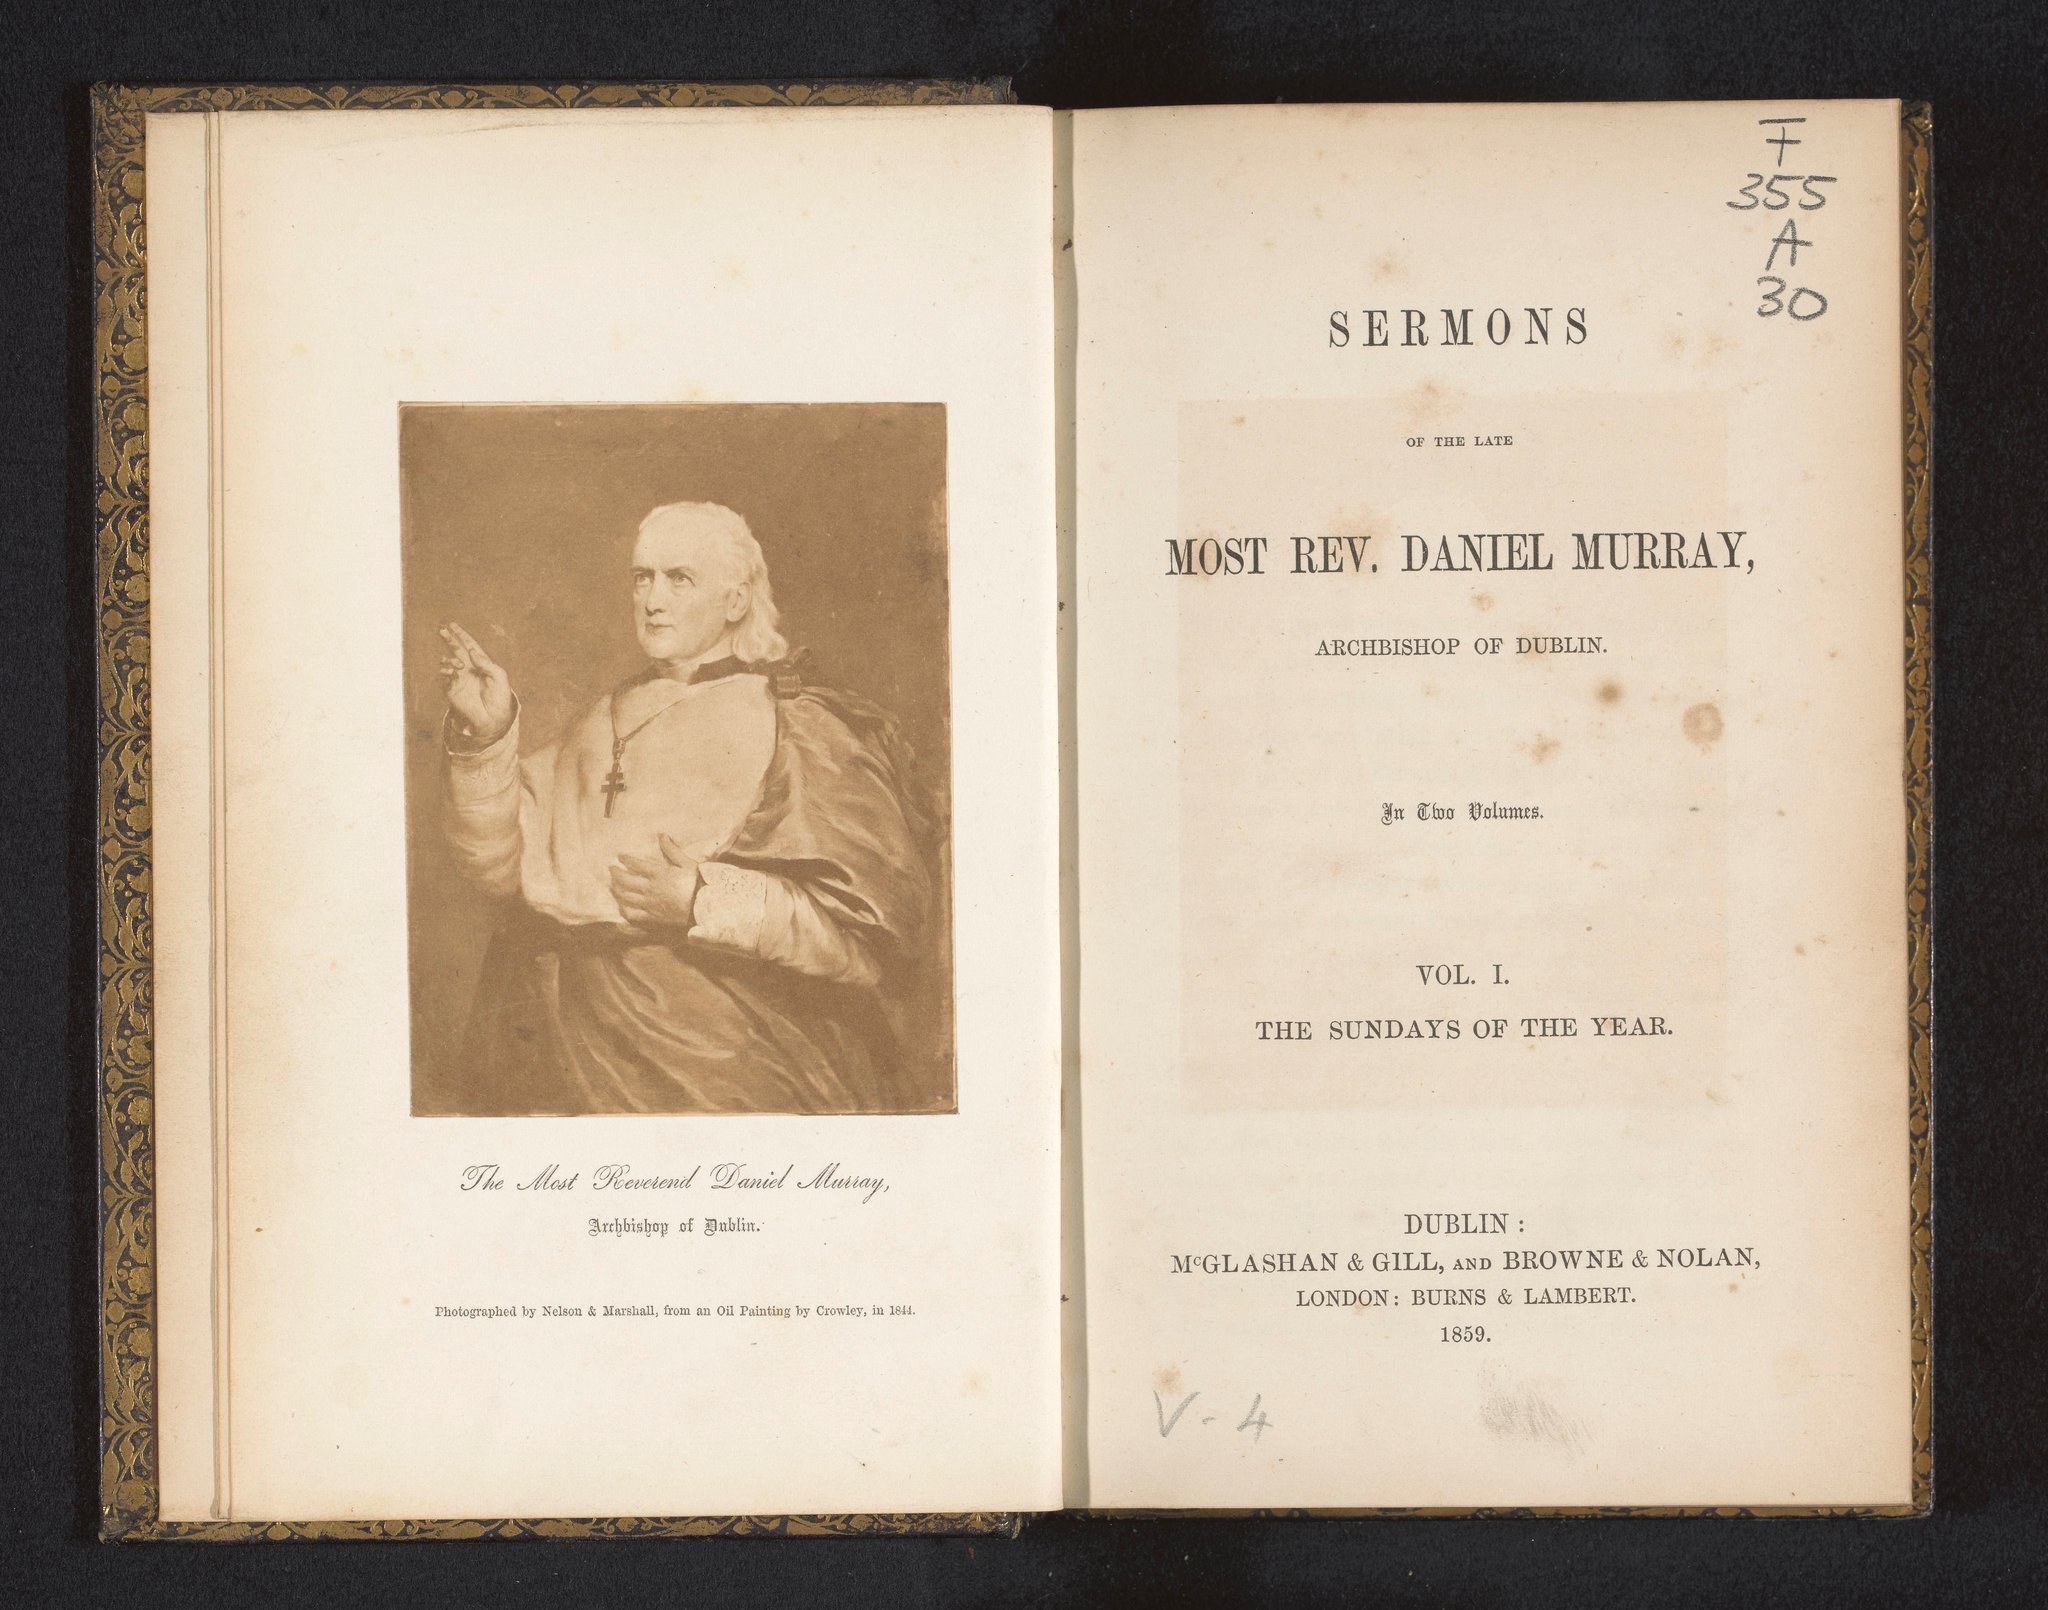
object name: page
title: The most reverend Daniel Murray, archbishop of Dublin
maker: nicholas joseph crowley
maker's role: painter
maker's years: 1819-1857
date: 1850-1859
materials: photographic support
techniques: albumen print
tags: daniel murray, archbishop, bishop, etc. (roman catholic)